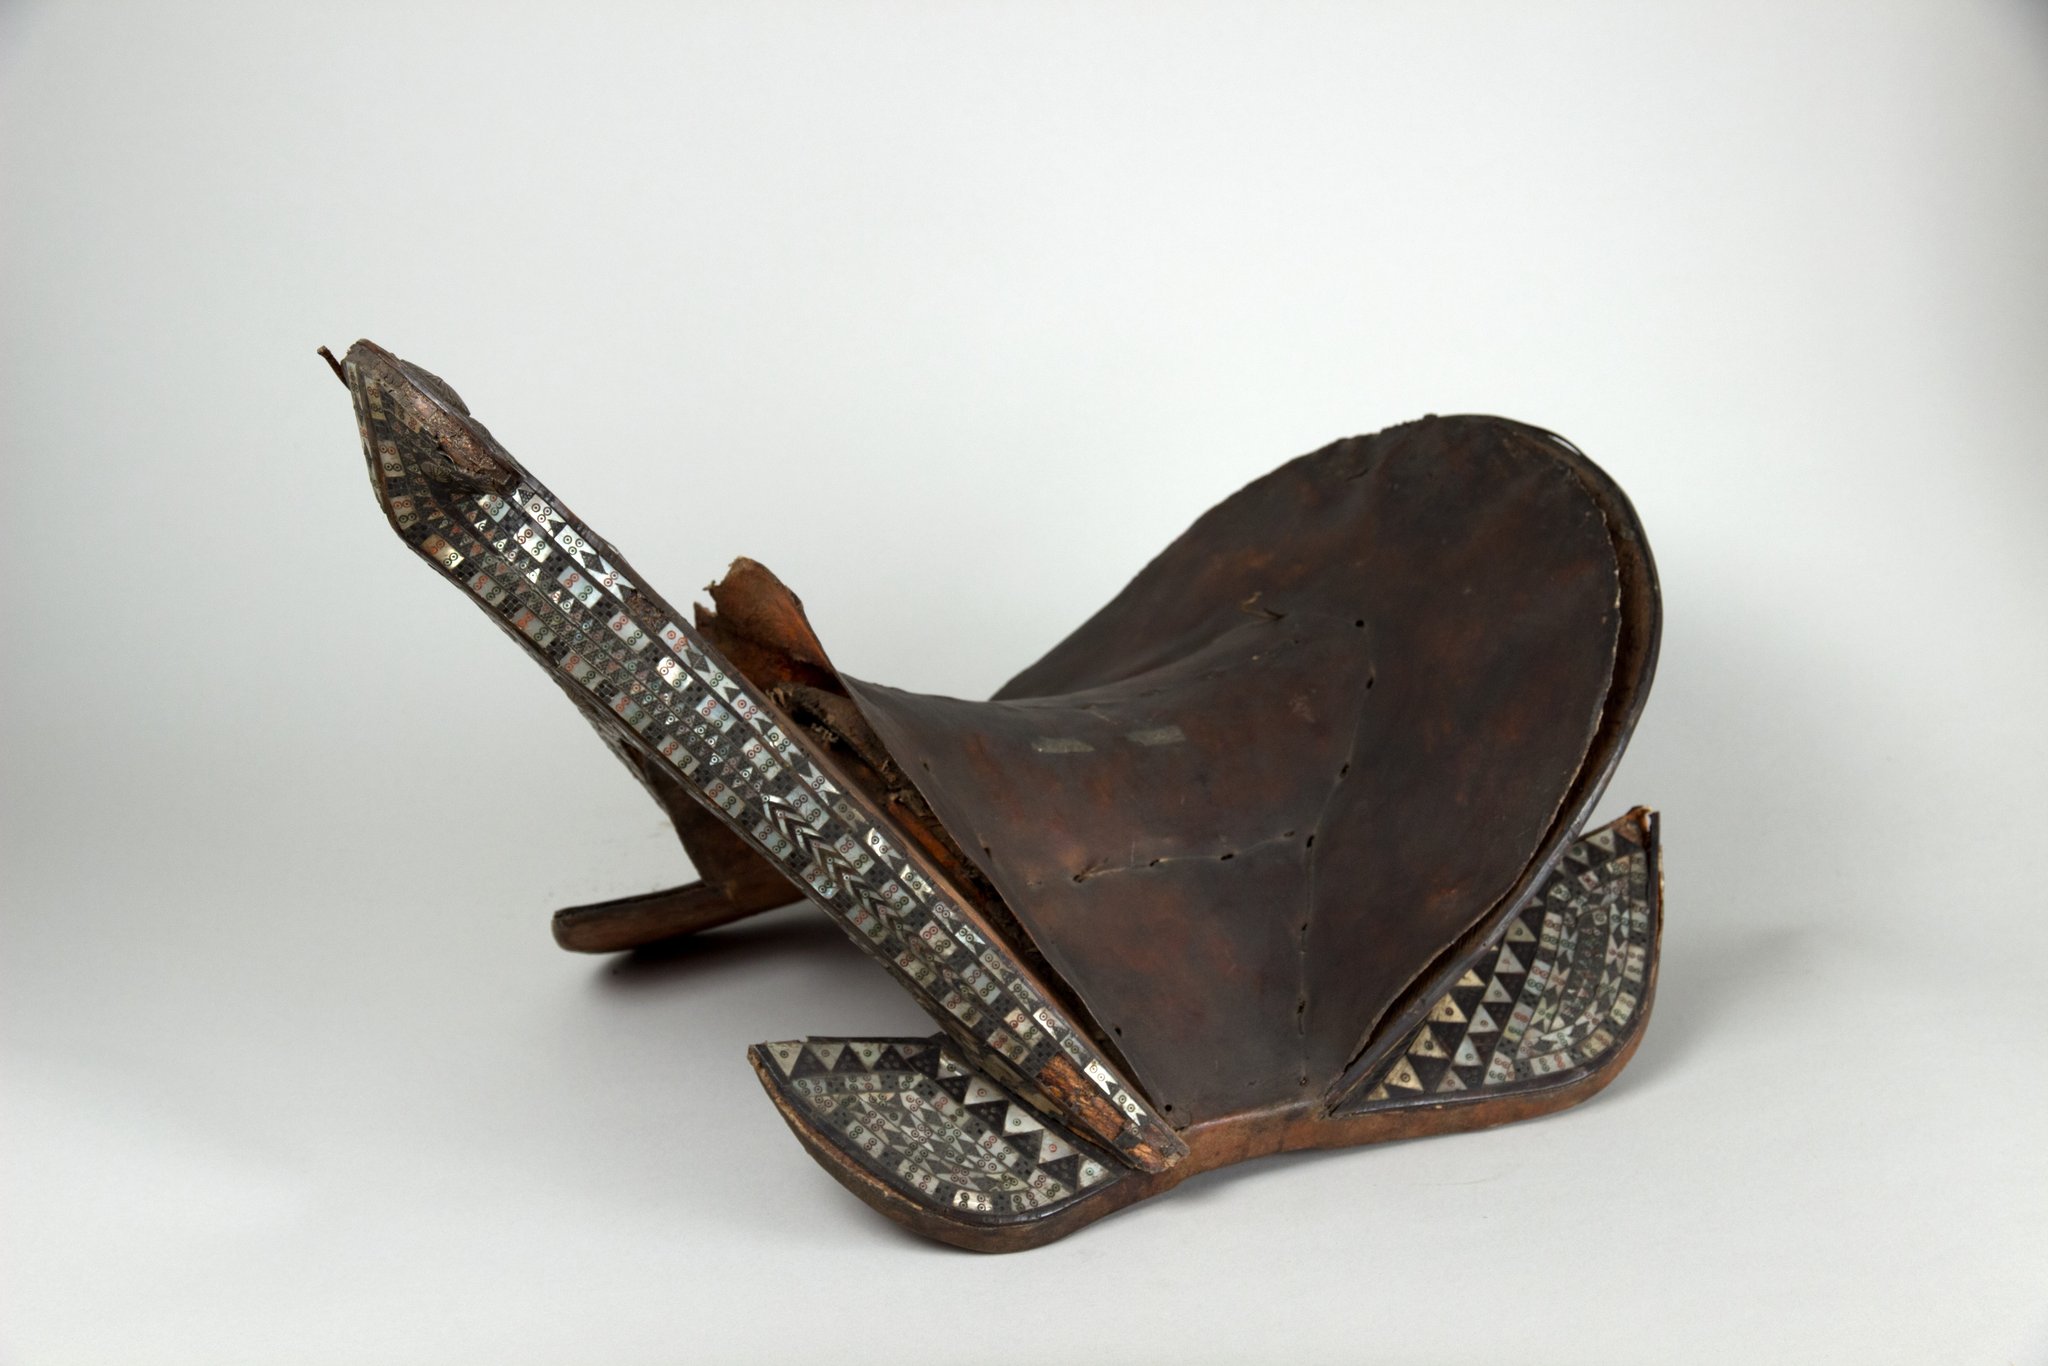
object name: saddle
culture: indian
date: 1801-1900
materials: horn, leather, mother of pearl, wood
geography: india